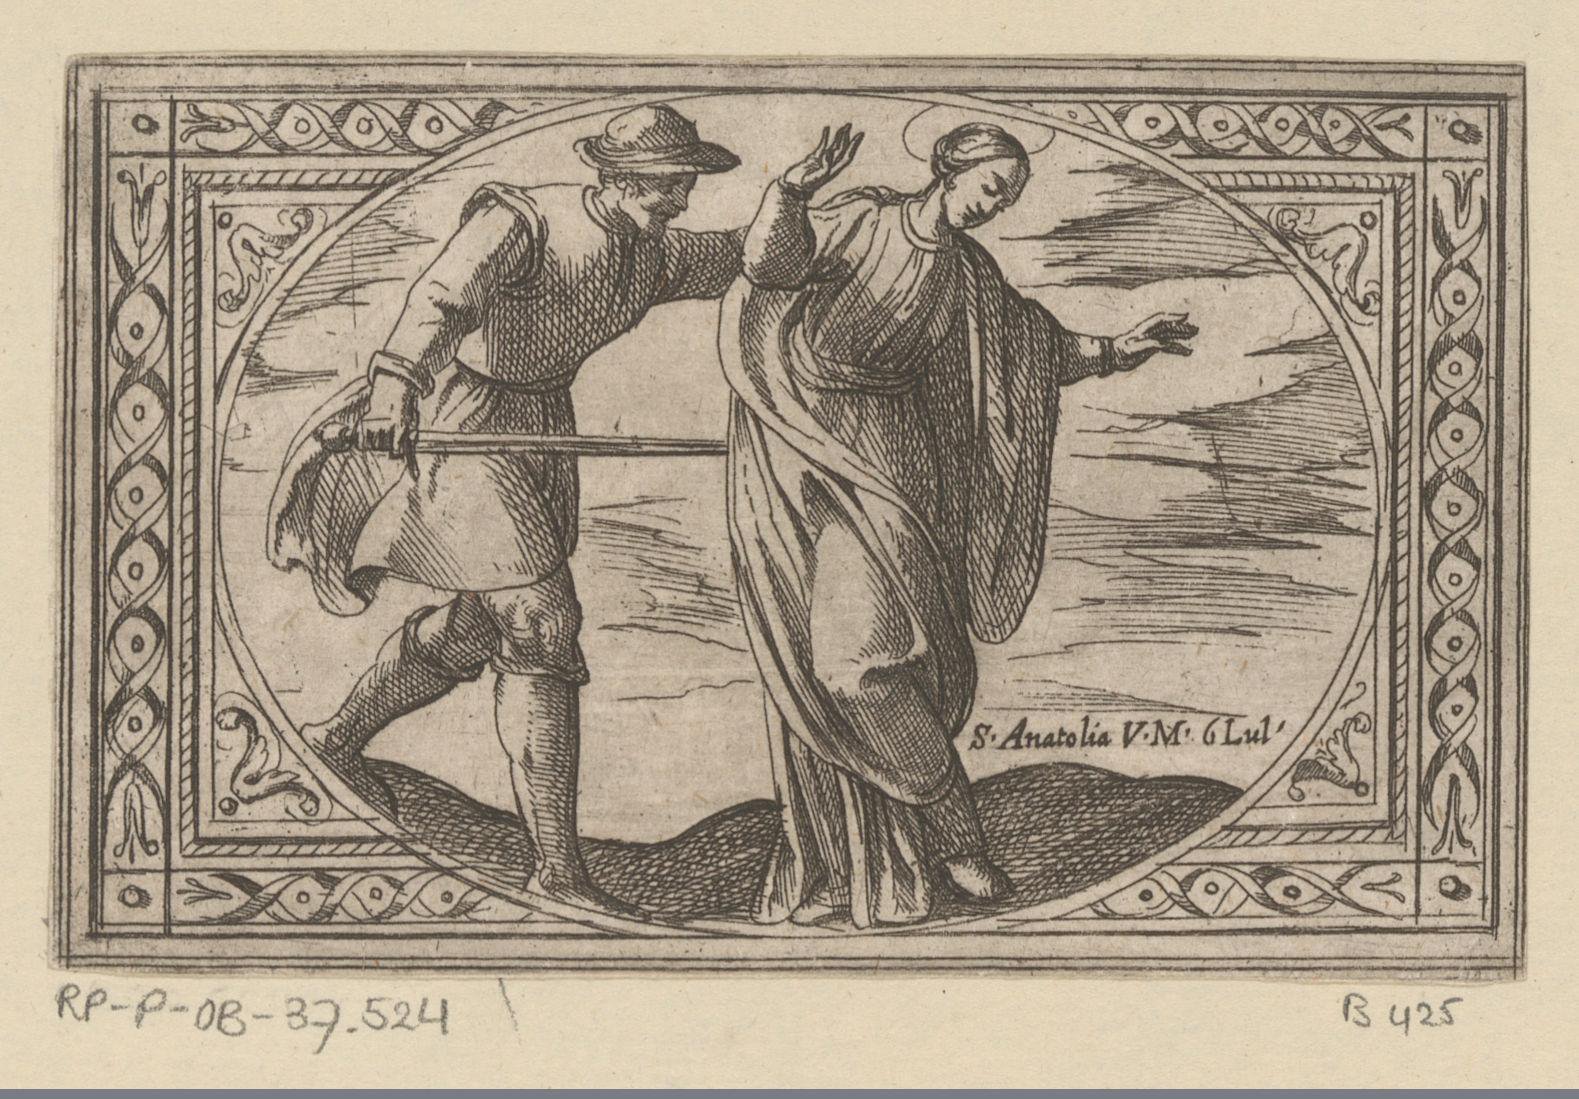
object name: print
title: Romeinse martelaressen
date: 1565-1630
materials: paper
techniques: etching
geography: rome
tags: martyr(s) (often with palm-branches) - qq - female martyr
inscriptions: collector's mark: Lugt 240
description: Deze prent maakt deel uit van een reeks van 73 prenten (+ titelprent) met voorstellingen van Romeinse martelaressen.